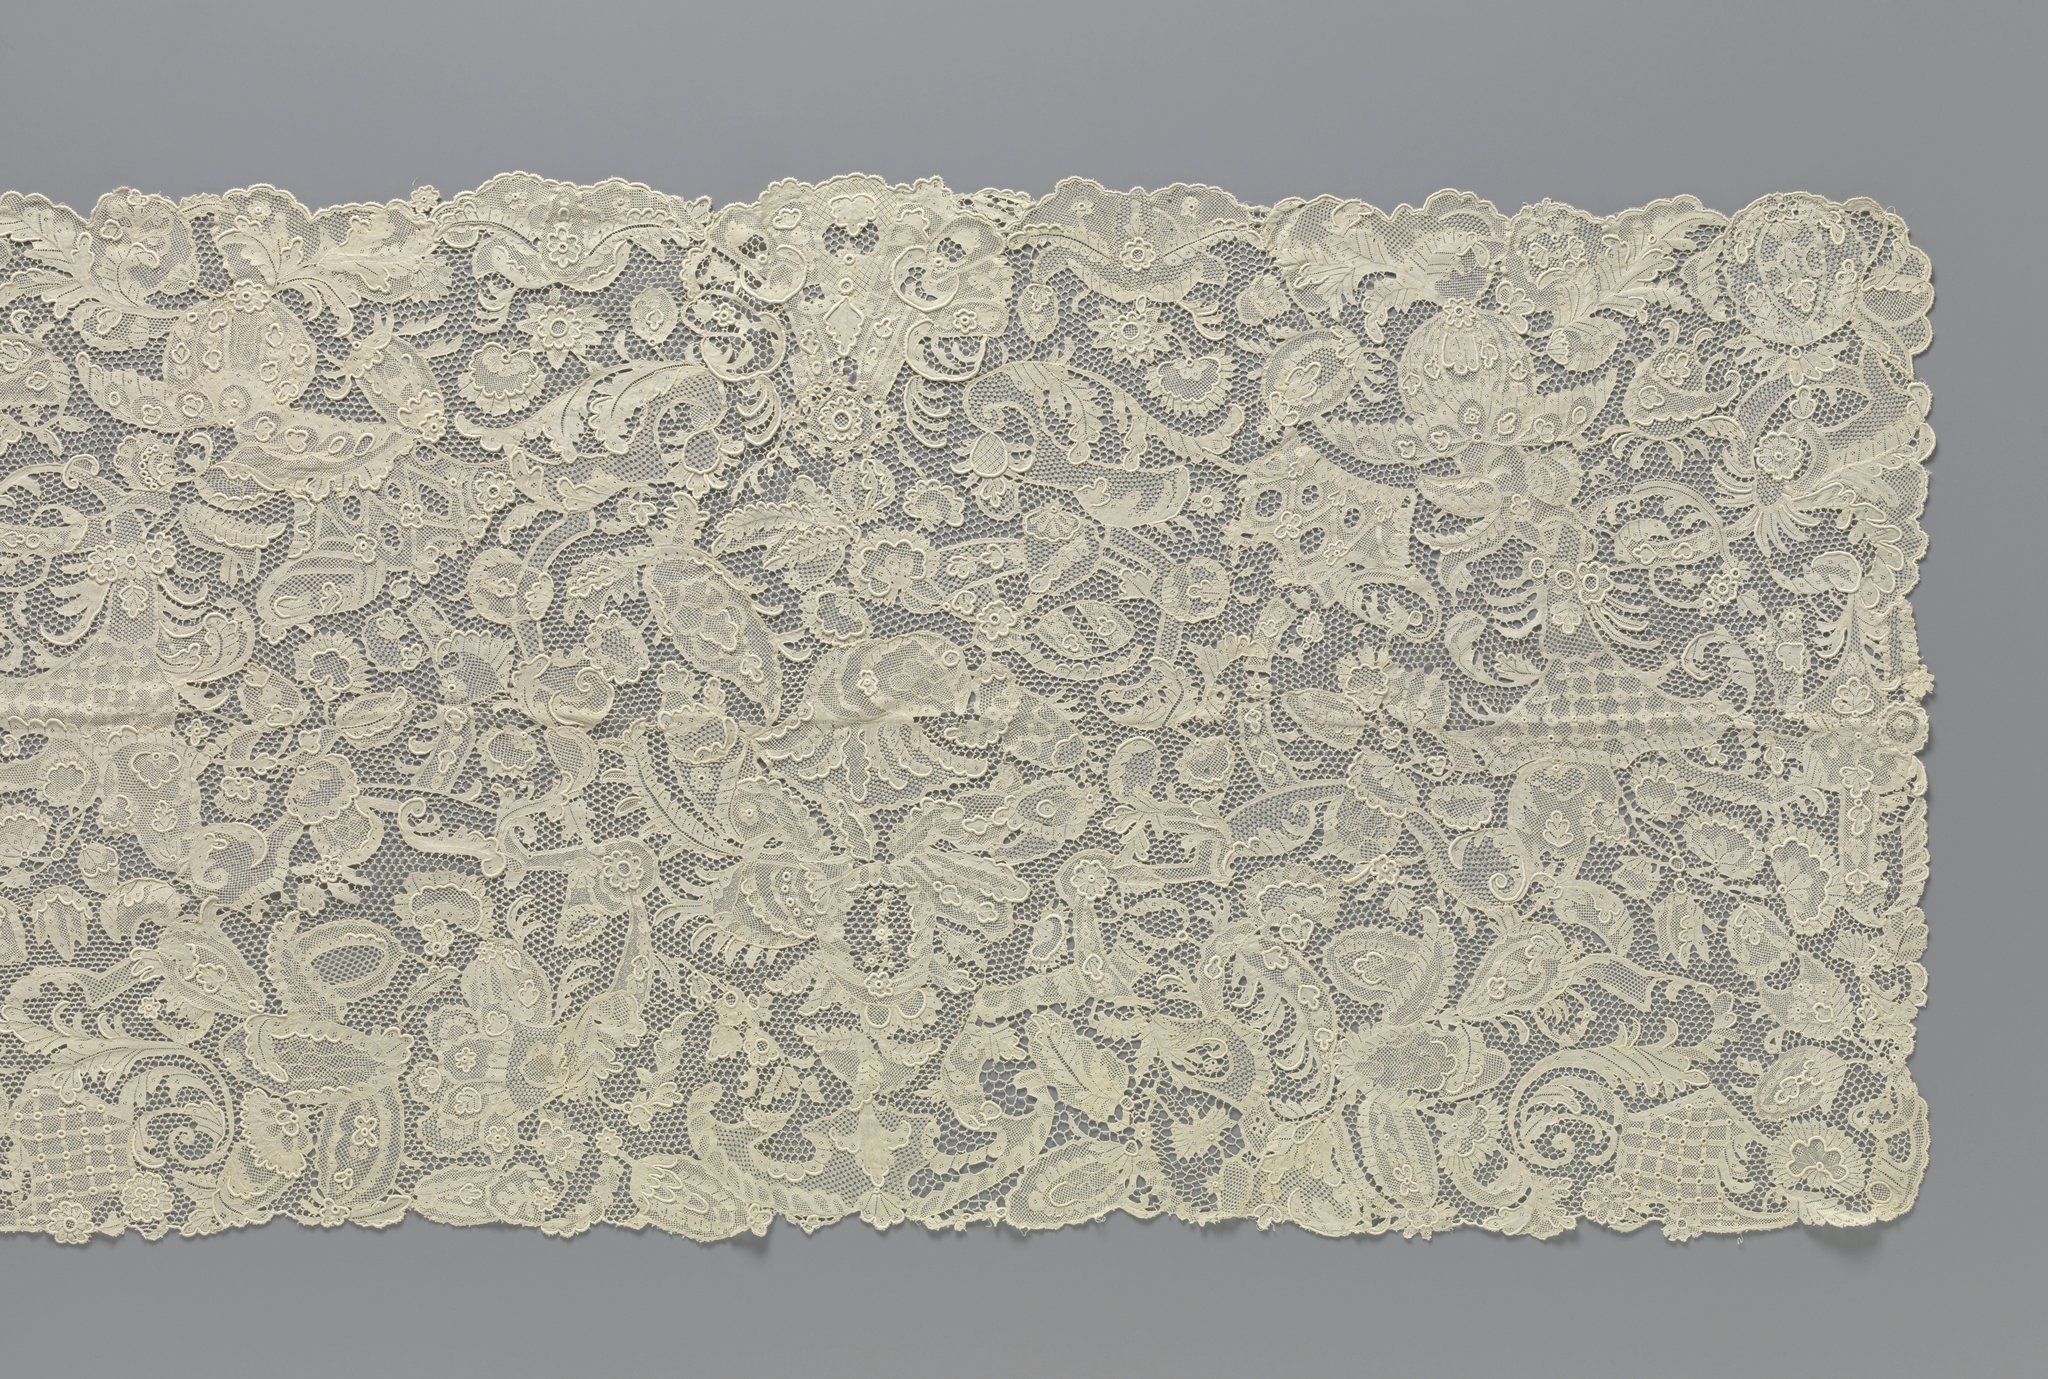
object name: albestrook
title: Albestrook van naaldkant met hoorns van overvloed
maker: Anonymous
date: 1900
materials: linen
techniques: lace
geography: france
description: Albestrook van naturelkleurige naaldkant: Sedan-kant of Argentan-kant. Patroon met bloemen, vruchten, schelpen en hoorns van overvloed. De motieven zijn gemaakt met festonsteken met uitsparingen, siersteken en siergronden. In verschillende motieven zijn delen geaccentueerd met cordons. De motieven zijn met elkaar verbonden door een zeshoekige maasgrond. De mazen zijn gefestoneerd en voorzien van picots. Schulpenranden langs alle zijden komen voort uit het patroon en zijn afgewerkt met picots.